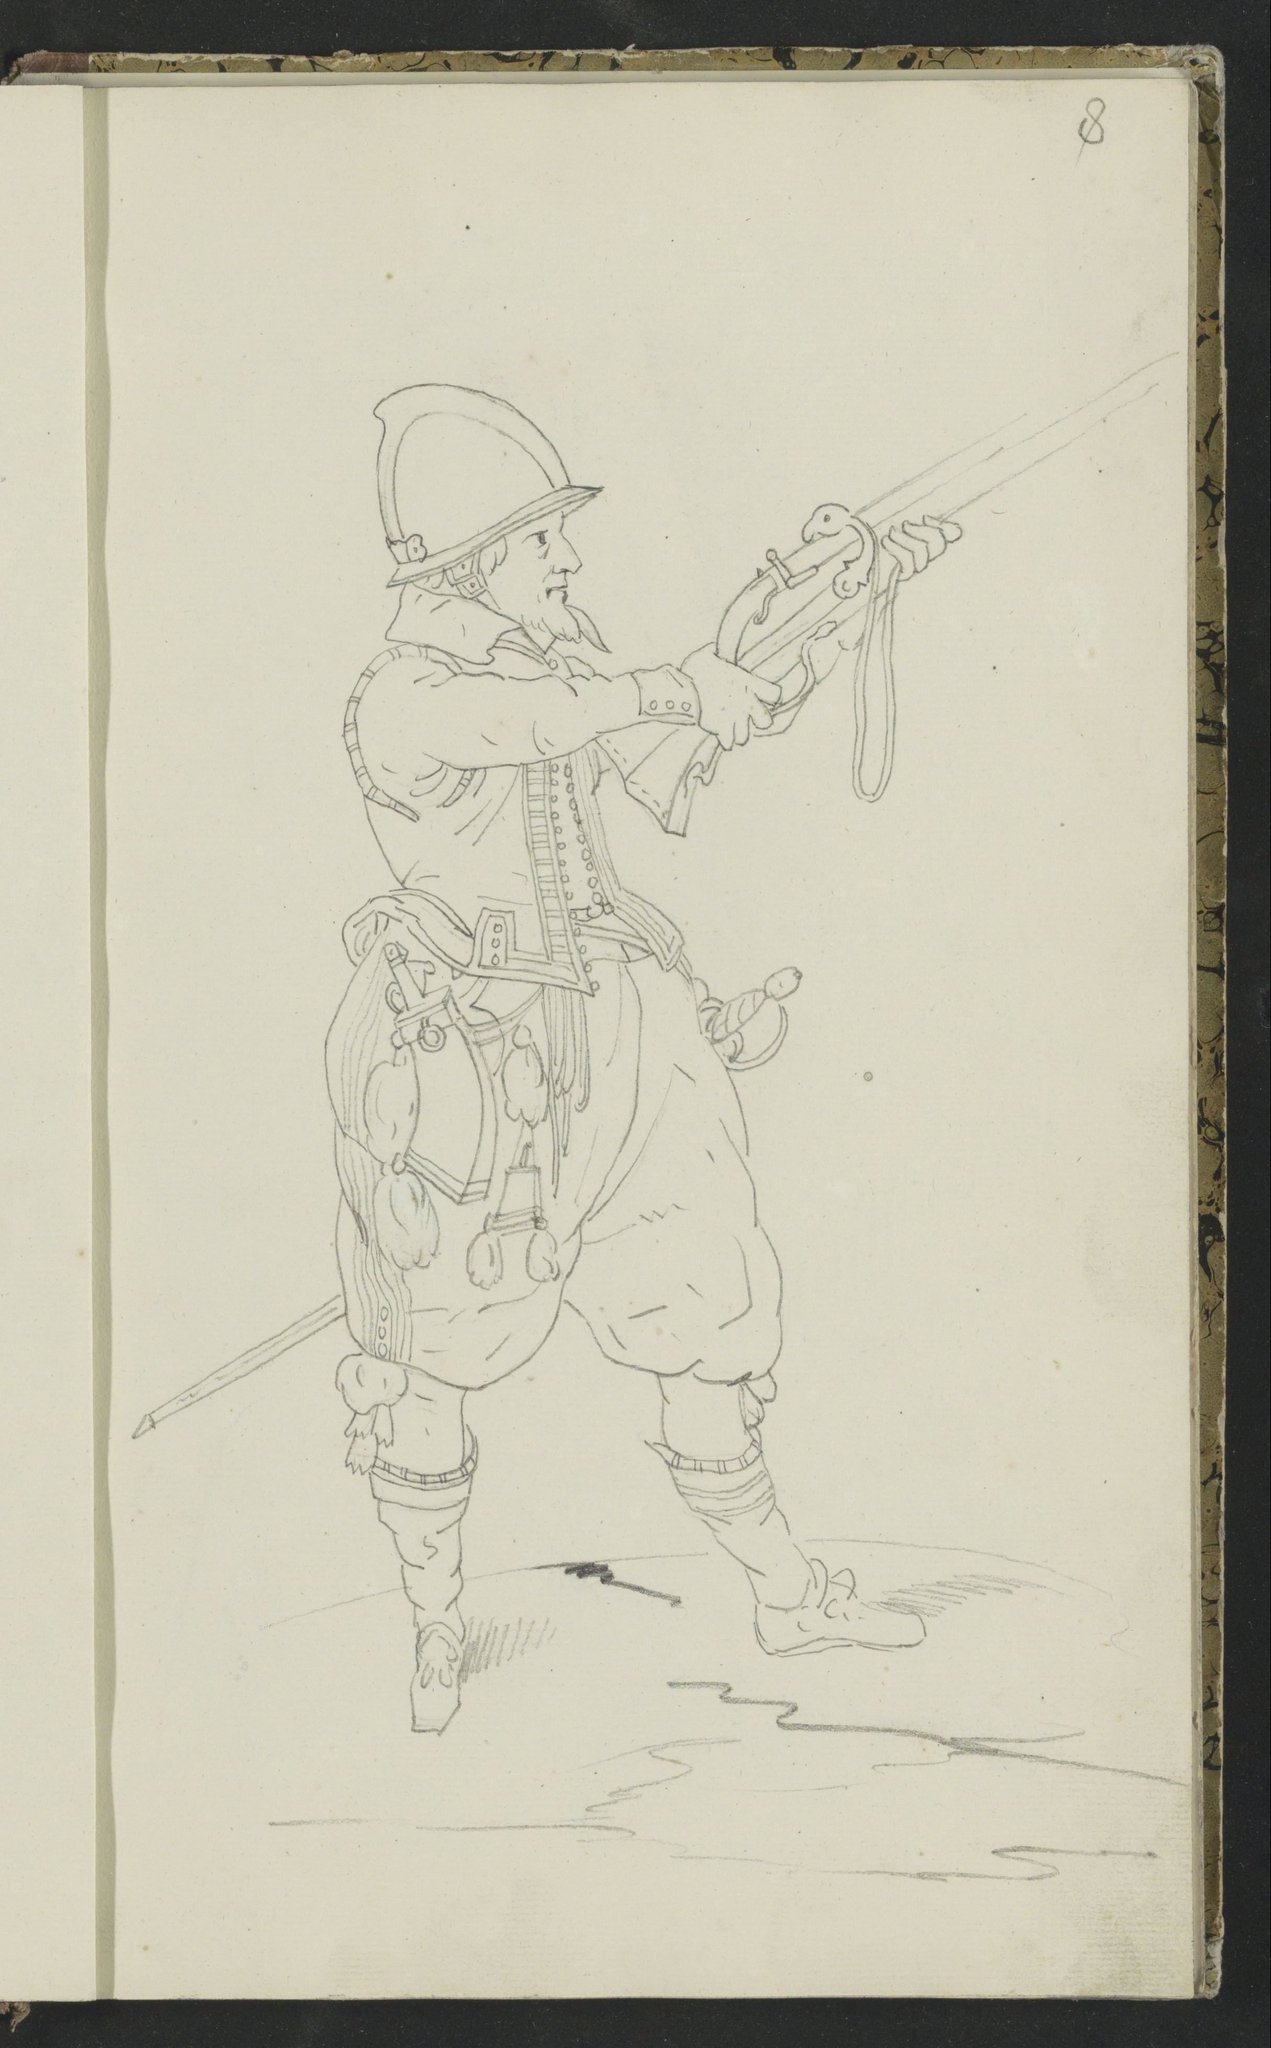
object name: sketchbook leaf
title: Soldaat die zijn musket richt en afvuurt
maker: johannes antonius canta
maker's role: draughtsman, painter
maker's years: 1816-1888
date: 1826-1888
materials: paper, pencil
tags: firearms, (military) uniforms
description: Kopie naar Jacob de Gheyns 'Wapenhandelinghe van roers musquetten ende spiessen: achtervolghende de ordre van syn excellentie Maurits prince van Orangie grave van Nassau &c' uit 1607. Blad 8 recto uit een schetsboek en album met 59 bladen.